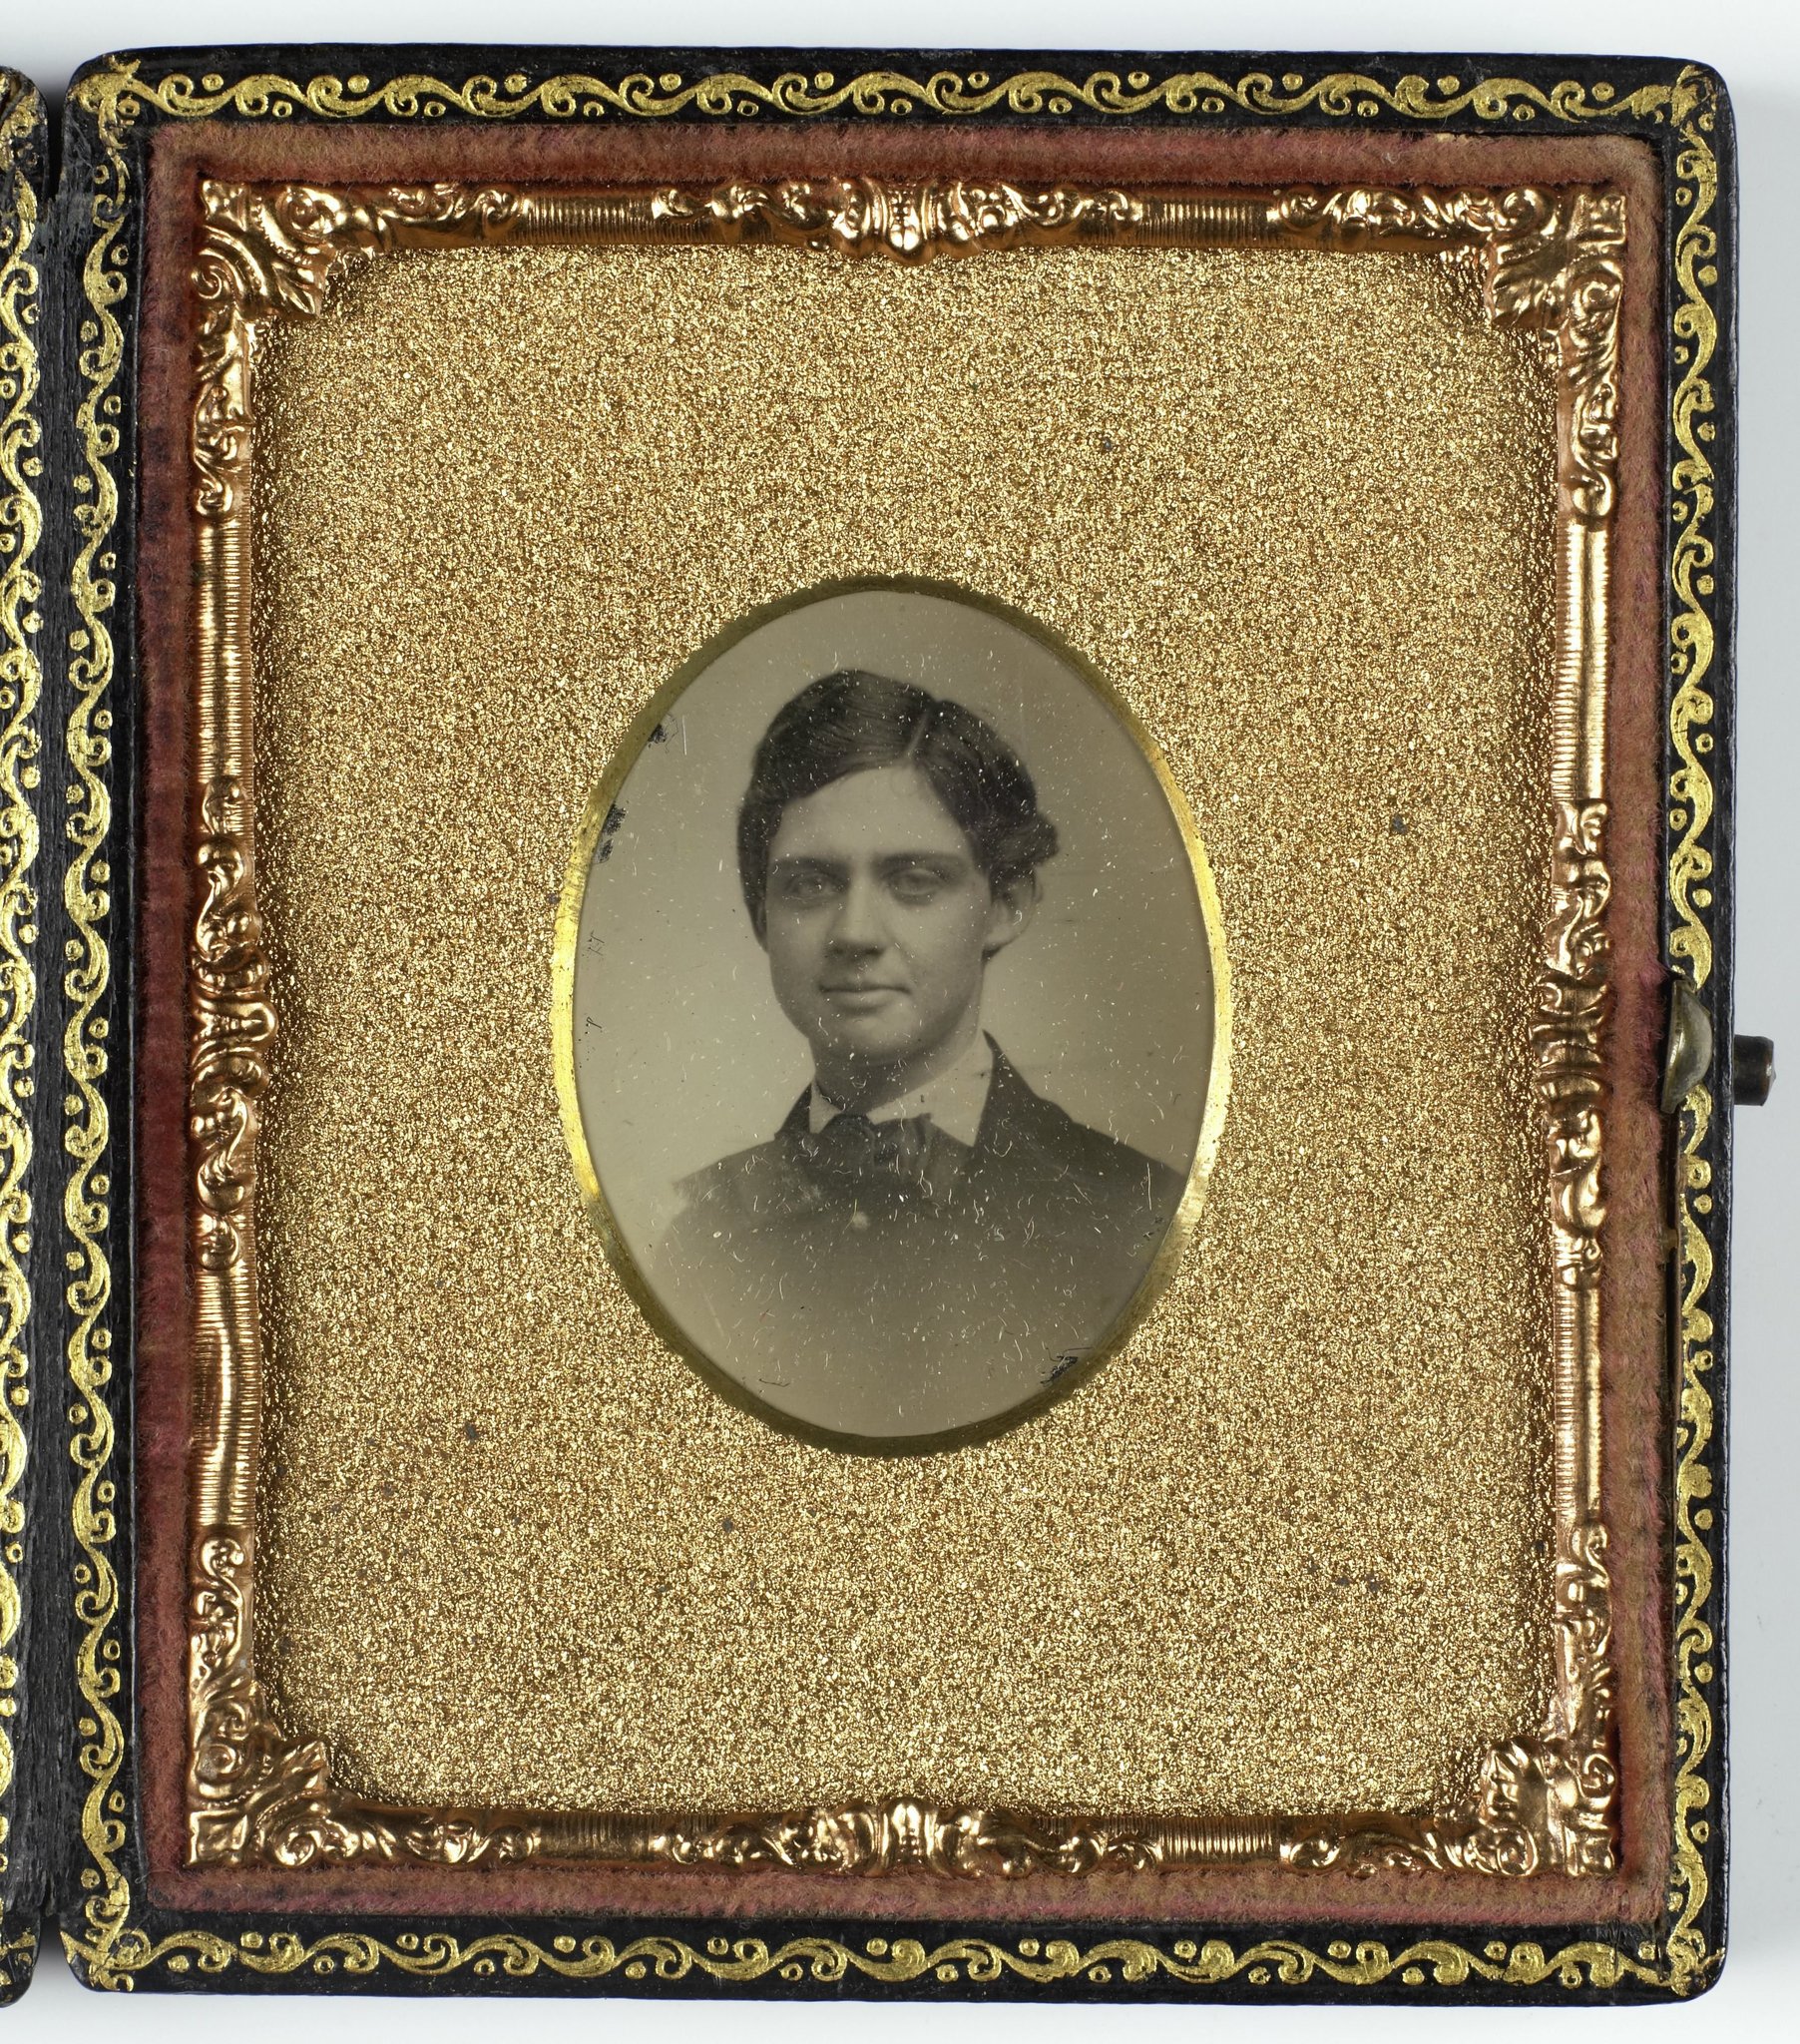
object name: photograph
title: Portret van een onbekende jonge man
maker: Anonymous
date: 1850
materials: copper, glass, mother of pearl, papier mâché, velvet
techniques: daguerreotype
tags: historical persons, youth, adolescent